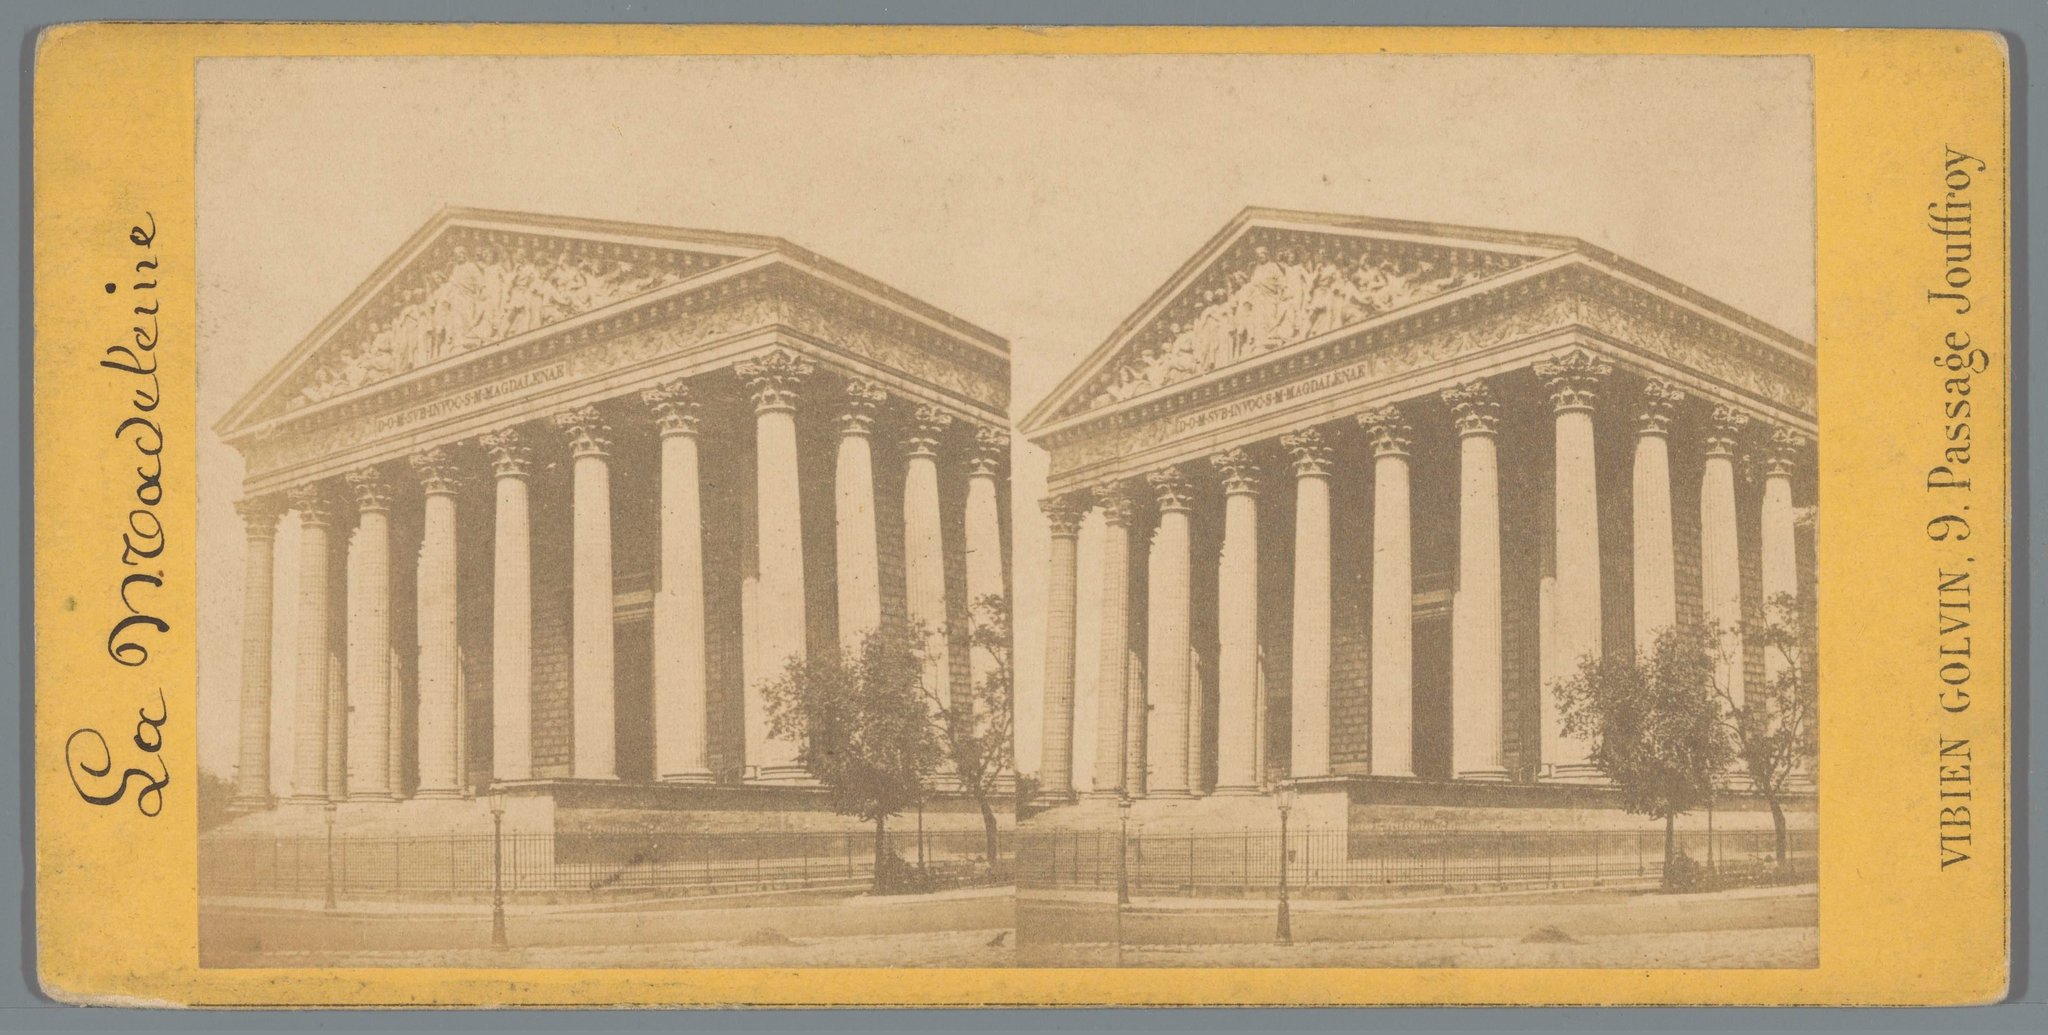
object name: stereograph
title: La Madeleine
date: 1850-1880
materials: cardboard, photographic support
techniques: albumen print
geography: paris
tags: parts of church exterior and annexes: façade